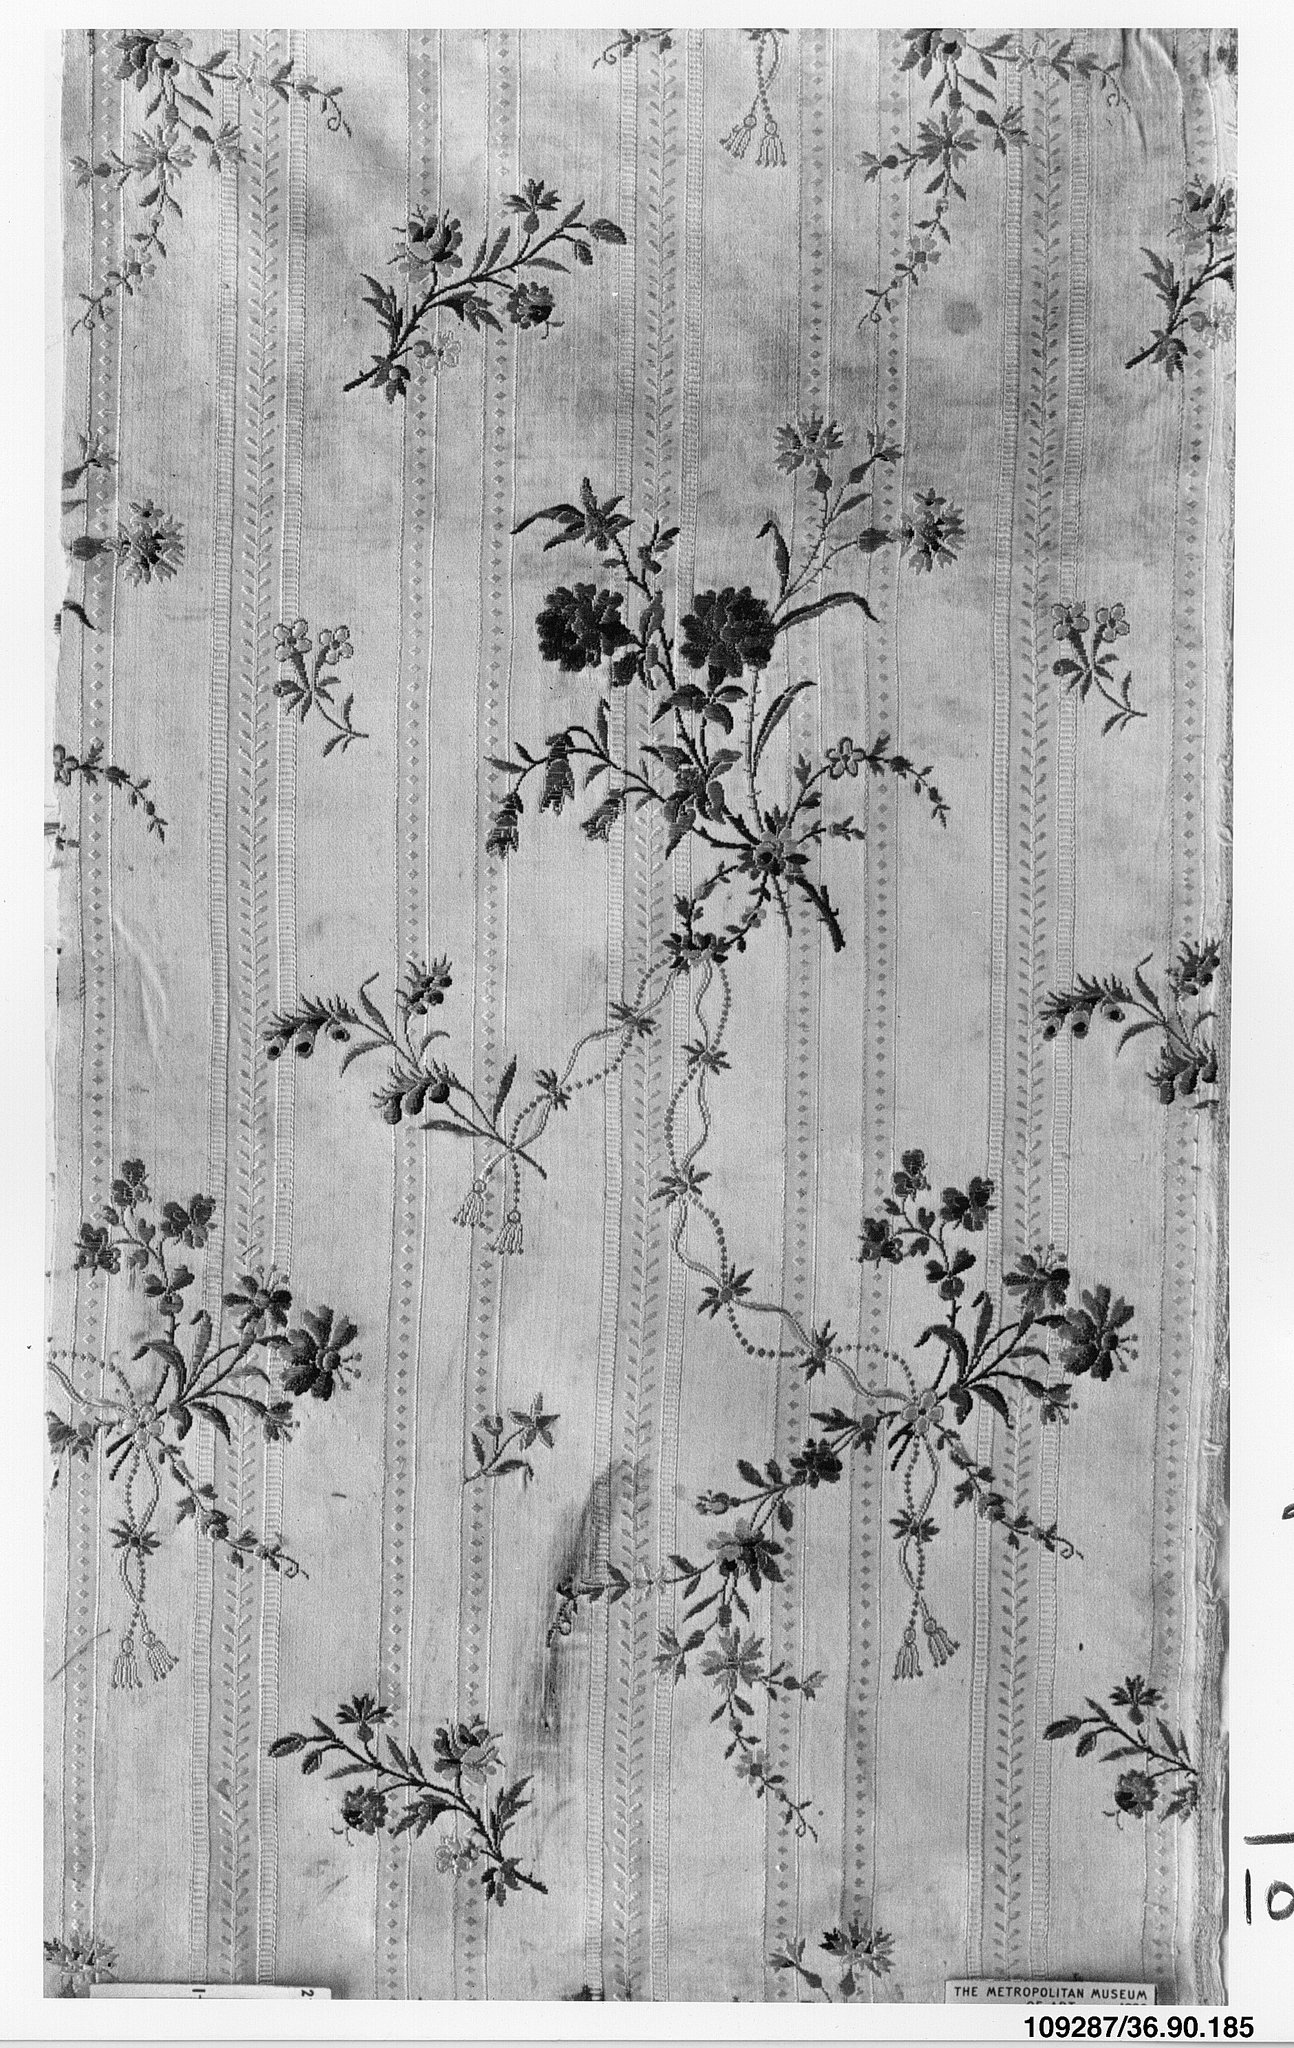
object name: piece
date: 1701-1800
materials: silk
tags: flowers,leaves